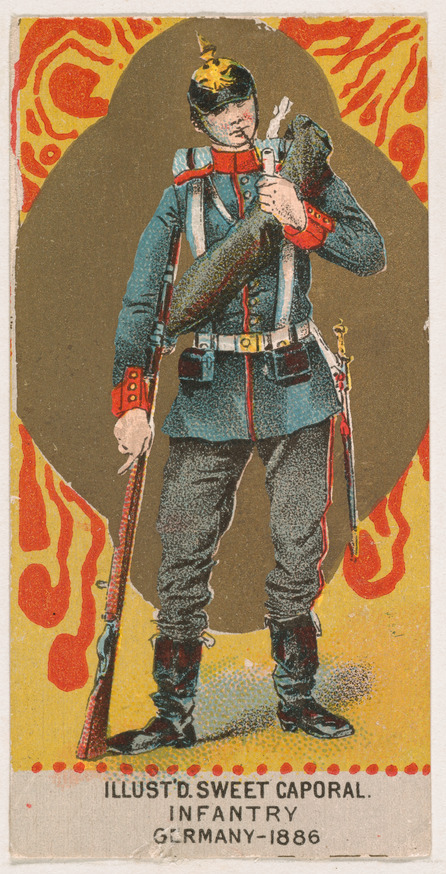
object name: print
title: Infantry, Germany, 1886, from the Military Series (N224) issued by Kinney Tobacco Company to promote Sweet Caporal Cigarettes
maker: kinney brothers tobacco company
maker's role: publisher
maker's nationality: american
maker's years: 1869-2011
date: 1888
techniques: color lithograph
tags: soldiers,firearms,men